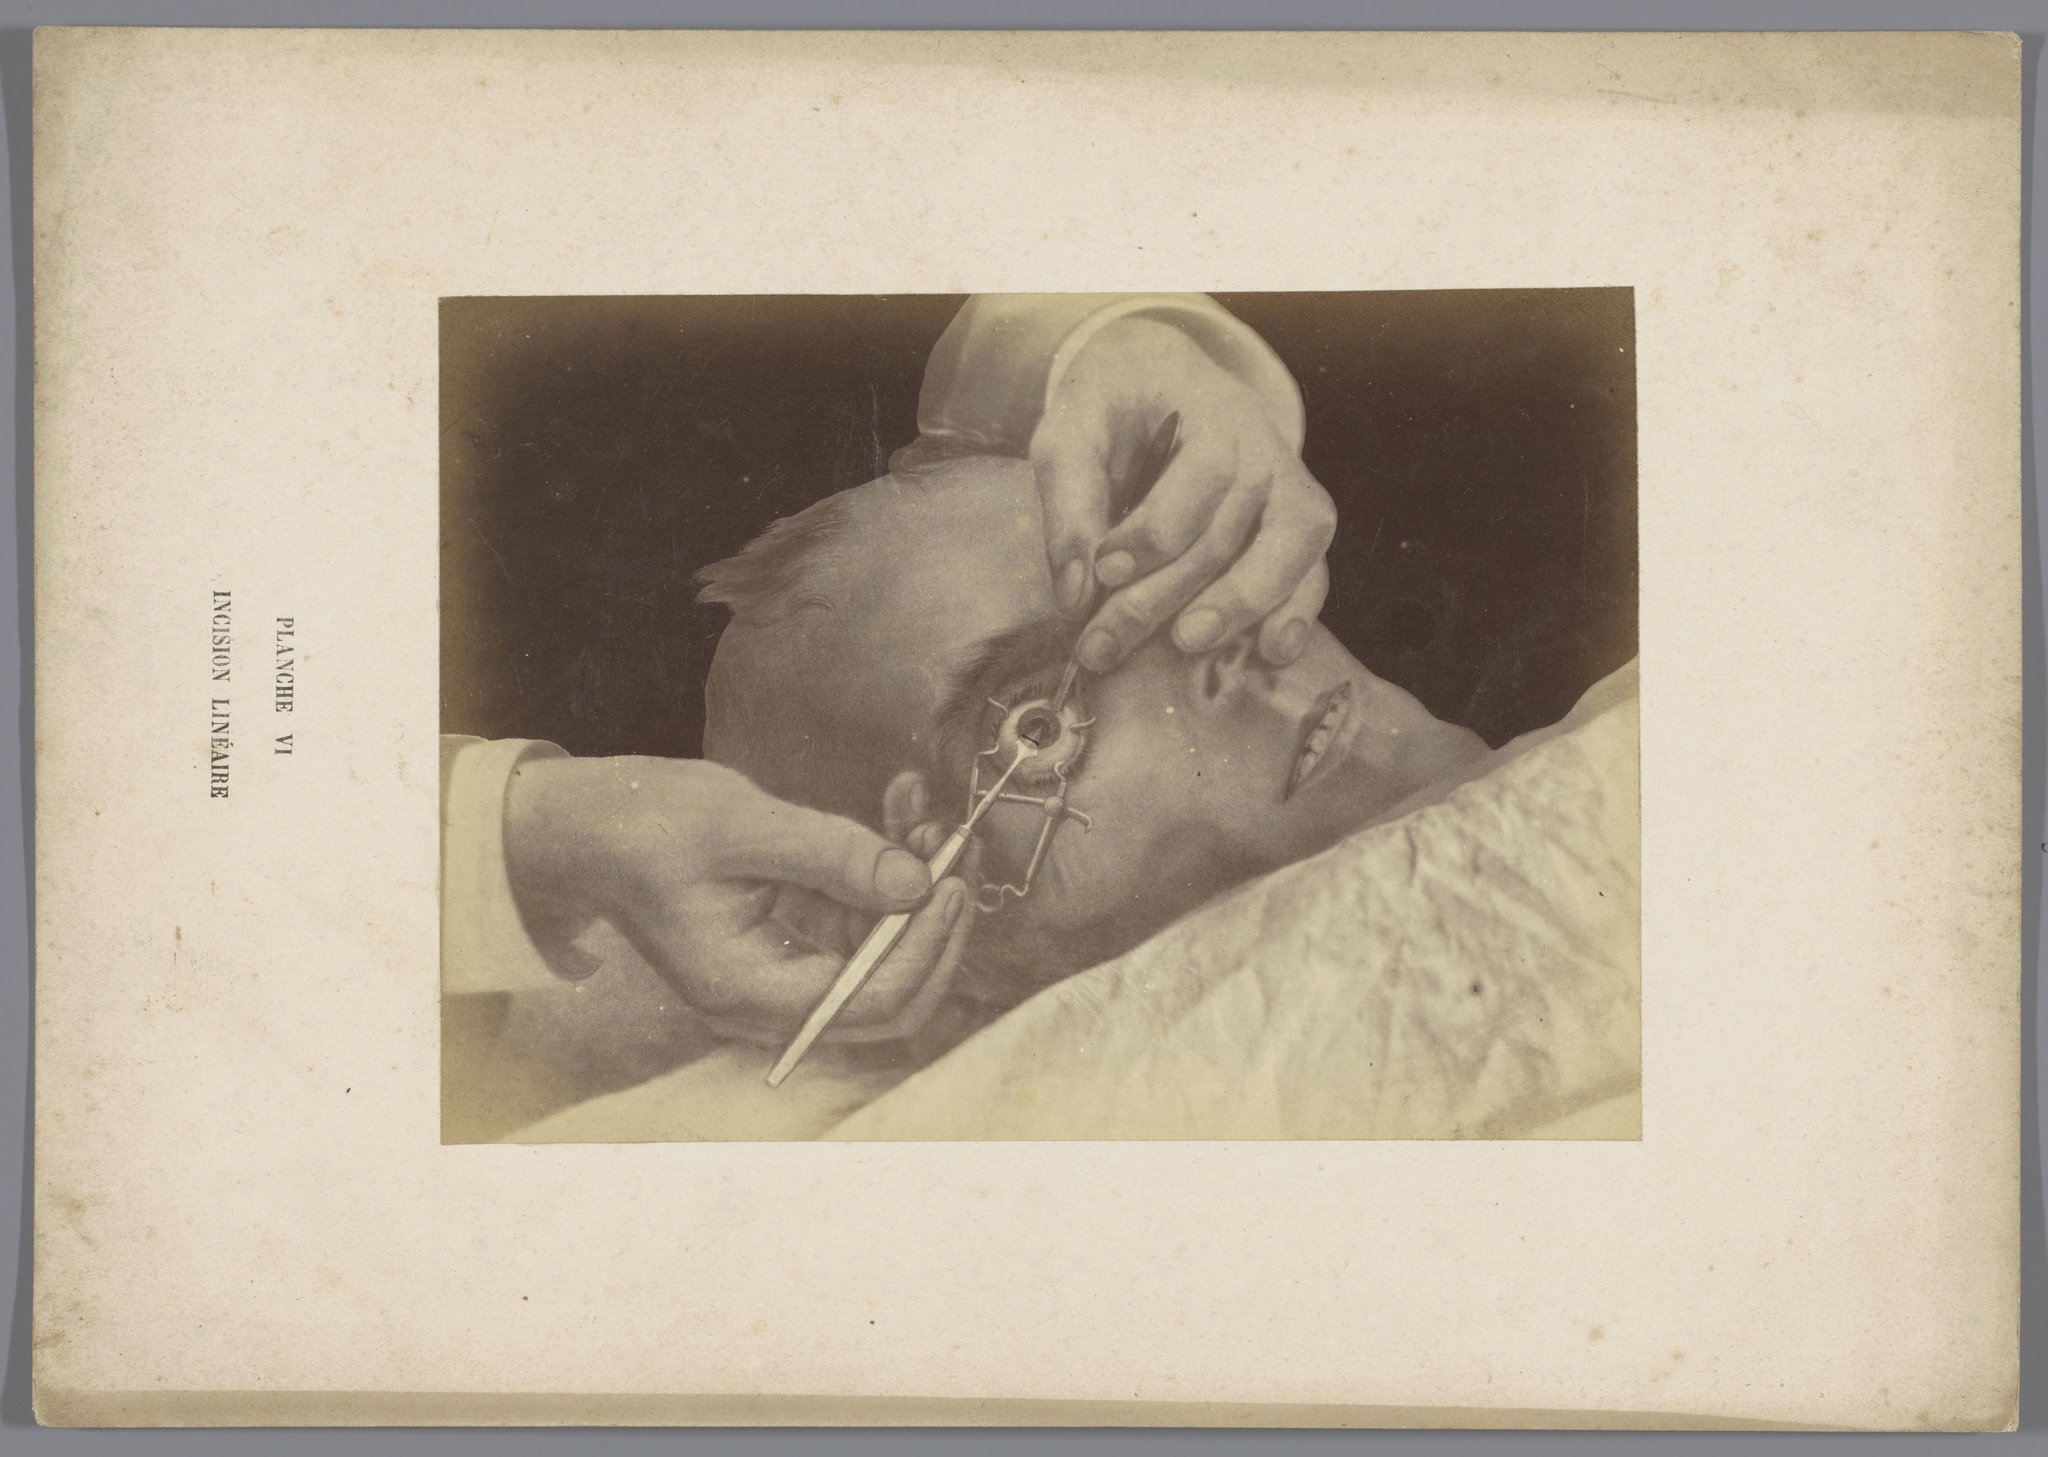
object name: photograph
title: Incision linéaire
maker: a. de montméja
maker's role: arts, fotograaf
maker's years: 1841-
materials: photographic support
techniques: albumen print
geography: france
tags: eyes, operation, surgery, disabilities affecting the eyes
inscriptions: number: ‘Planche VI’